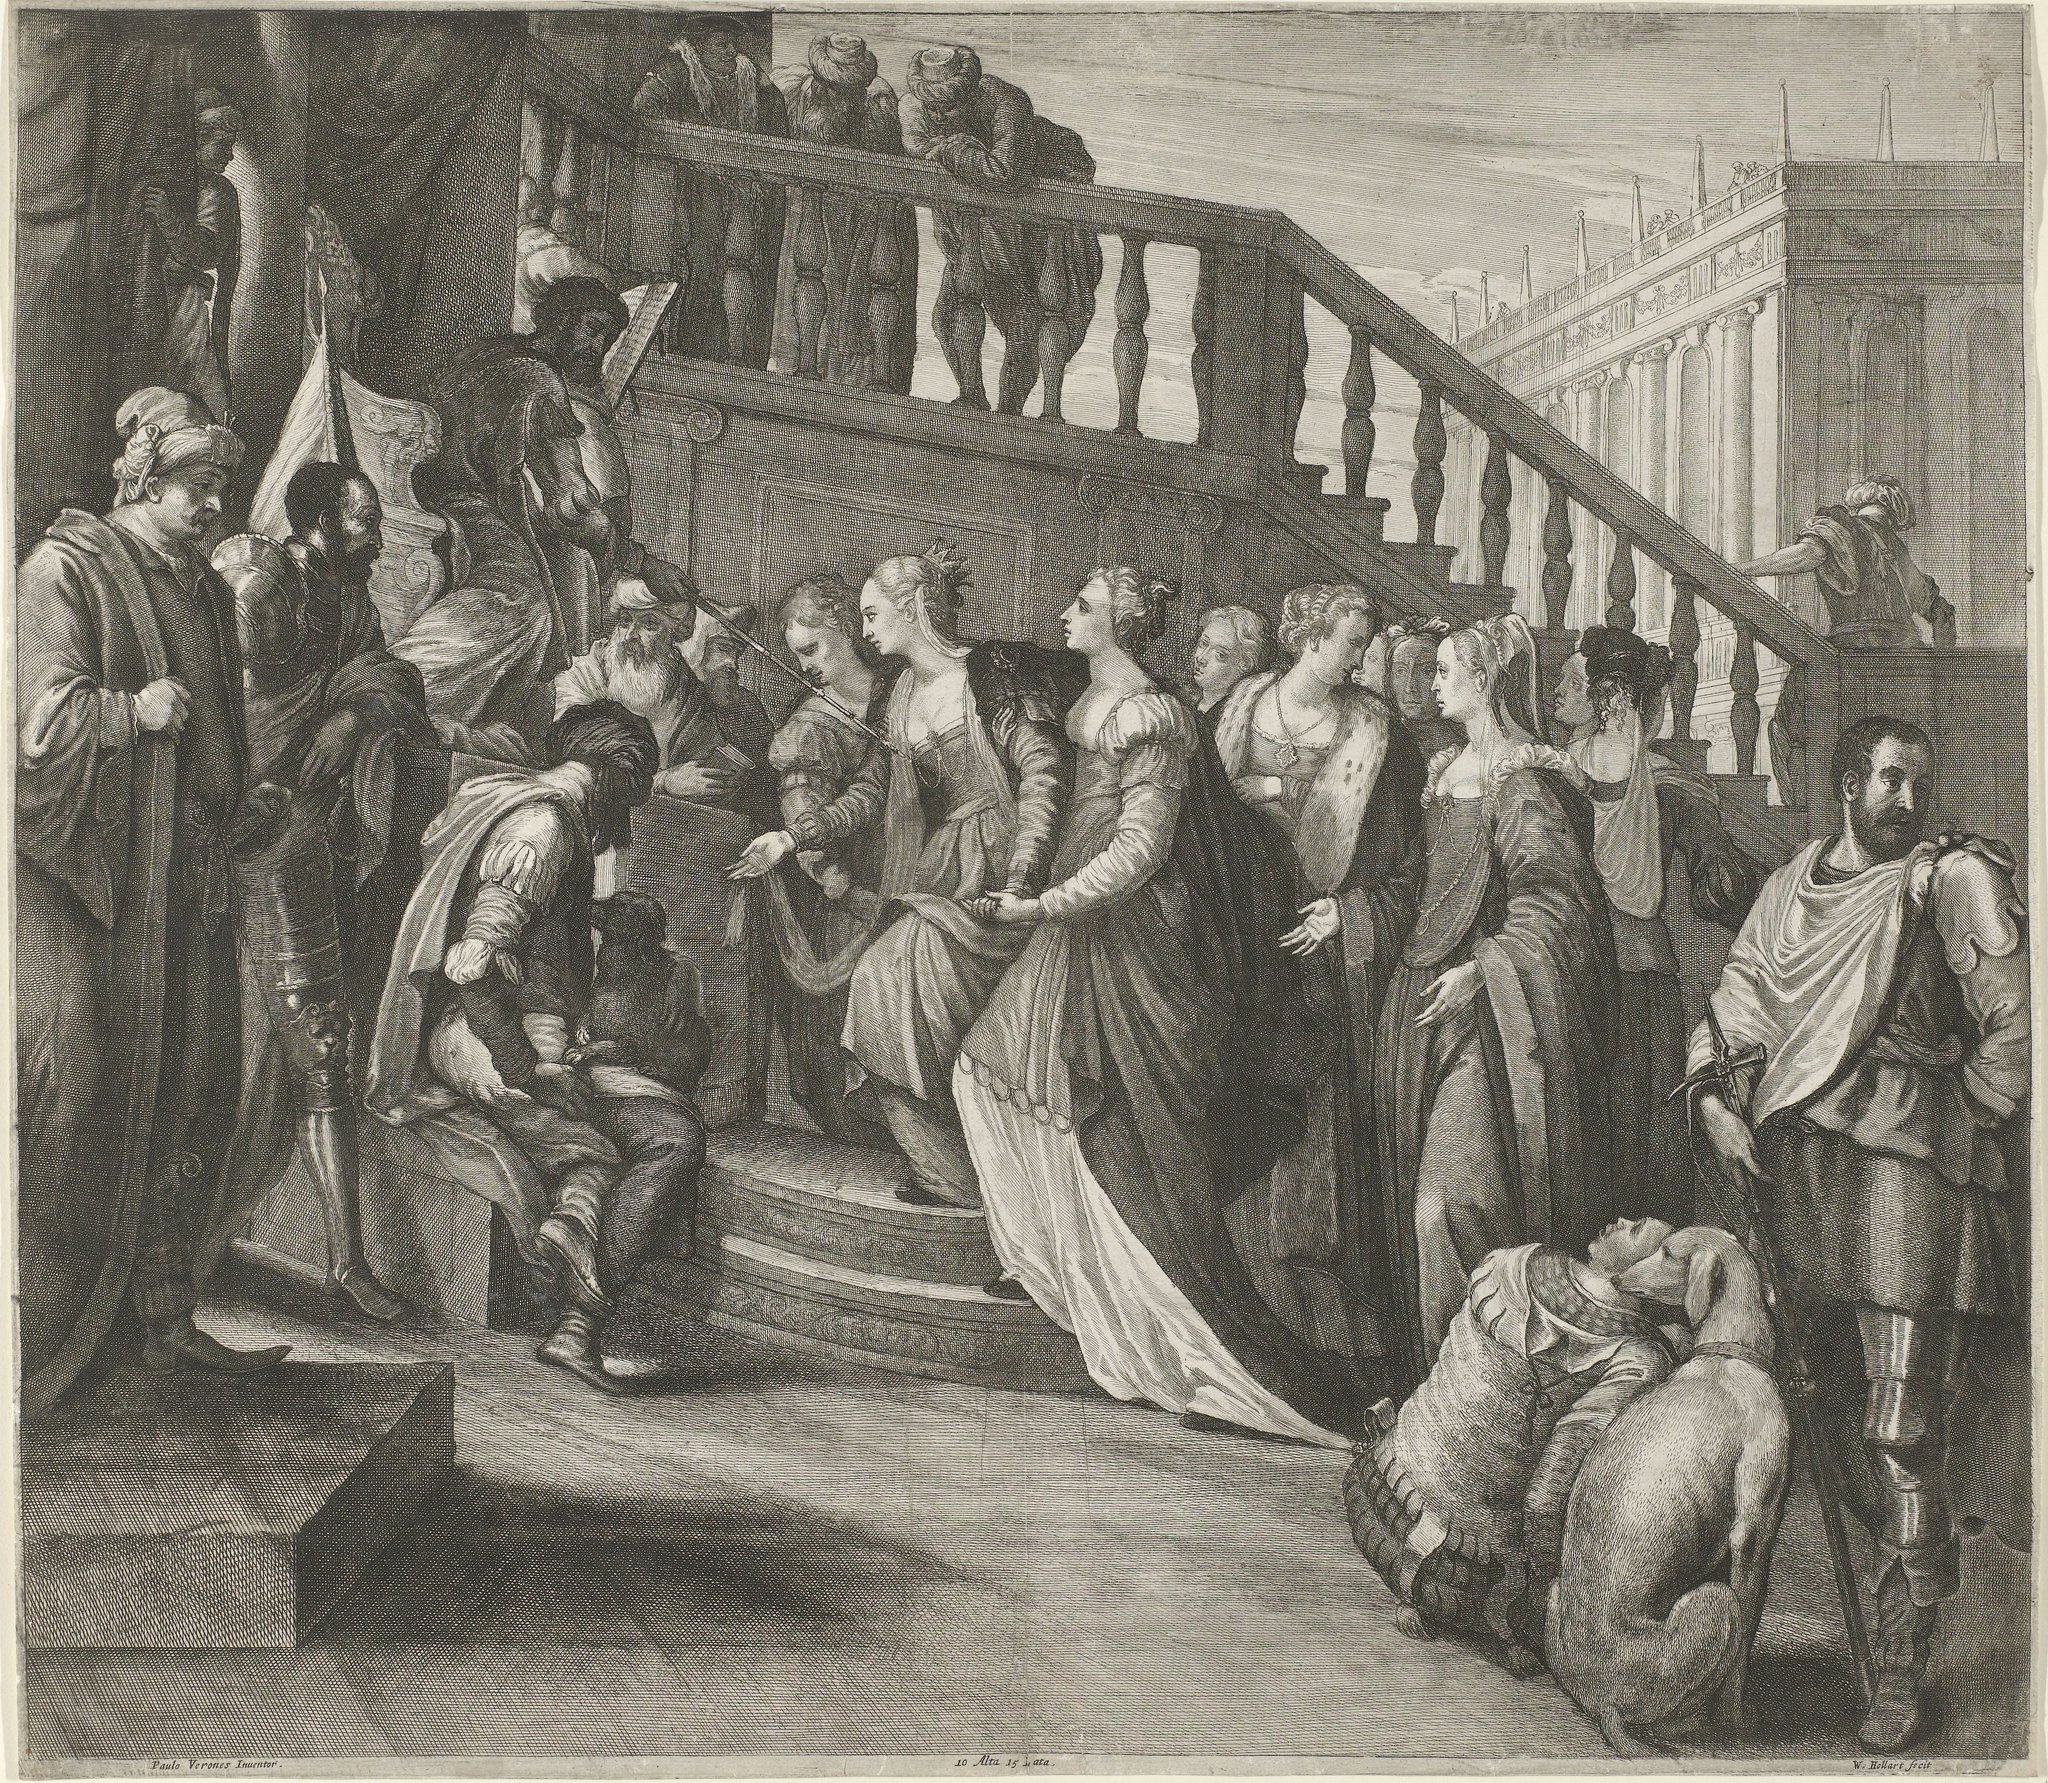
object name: print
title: Esther voor Ahasveros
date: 1644-1652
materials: paper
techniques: etching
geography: antwerp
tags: esther before ahasuerus (esther 5:1-4)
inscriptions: collector's mark: Lugt 240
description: Esther, vergezeld door haar dienstmaagden, knielt voor koning Ahasveros. De koning stapt van zijn troon en reikt haar een scepter aan, ten teken dat hij genegen is haar te ontvangen.